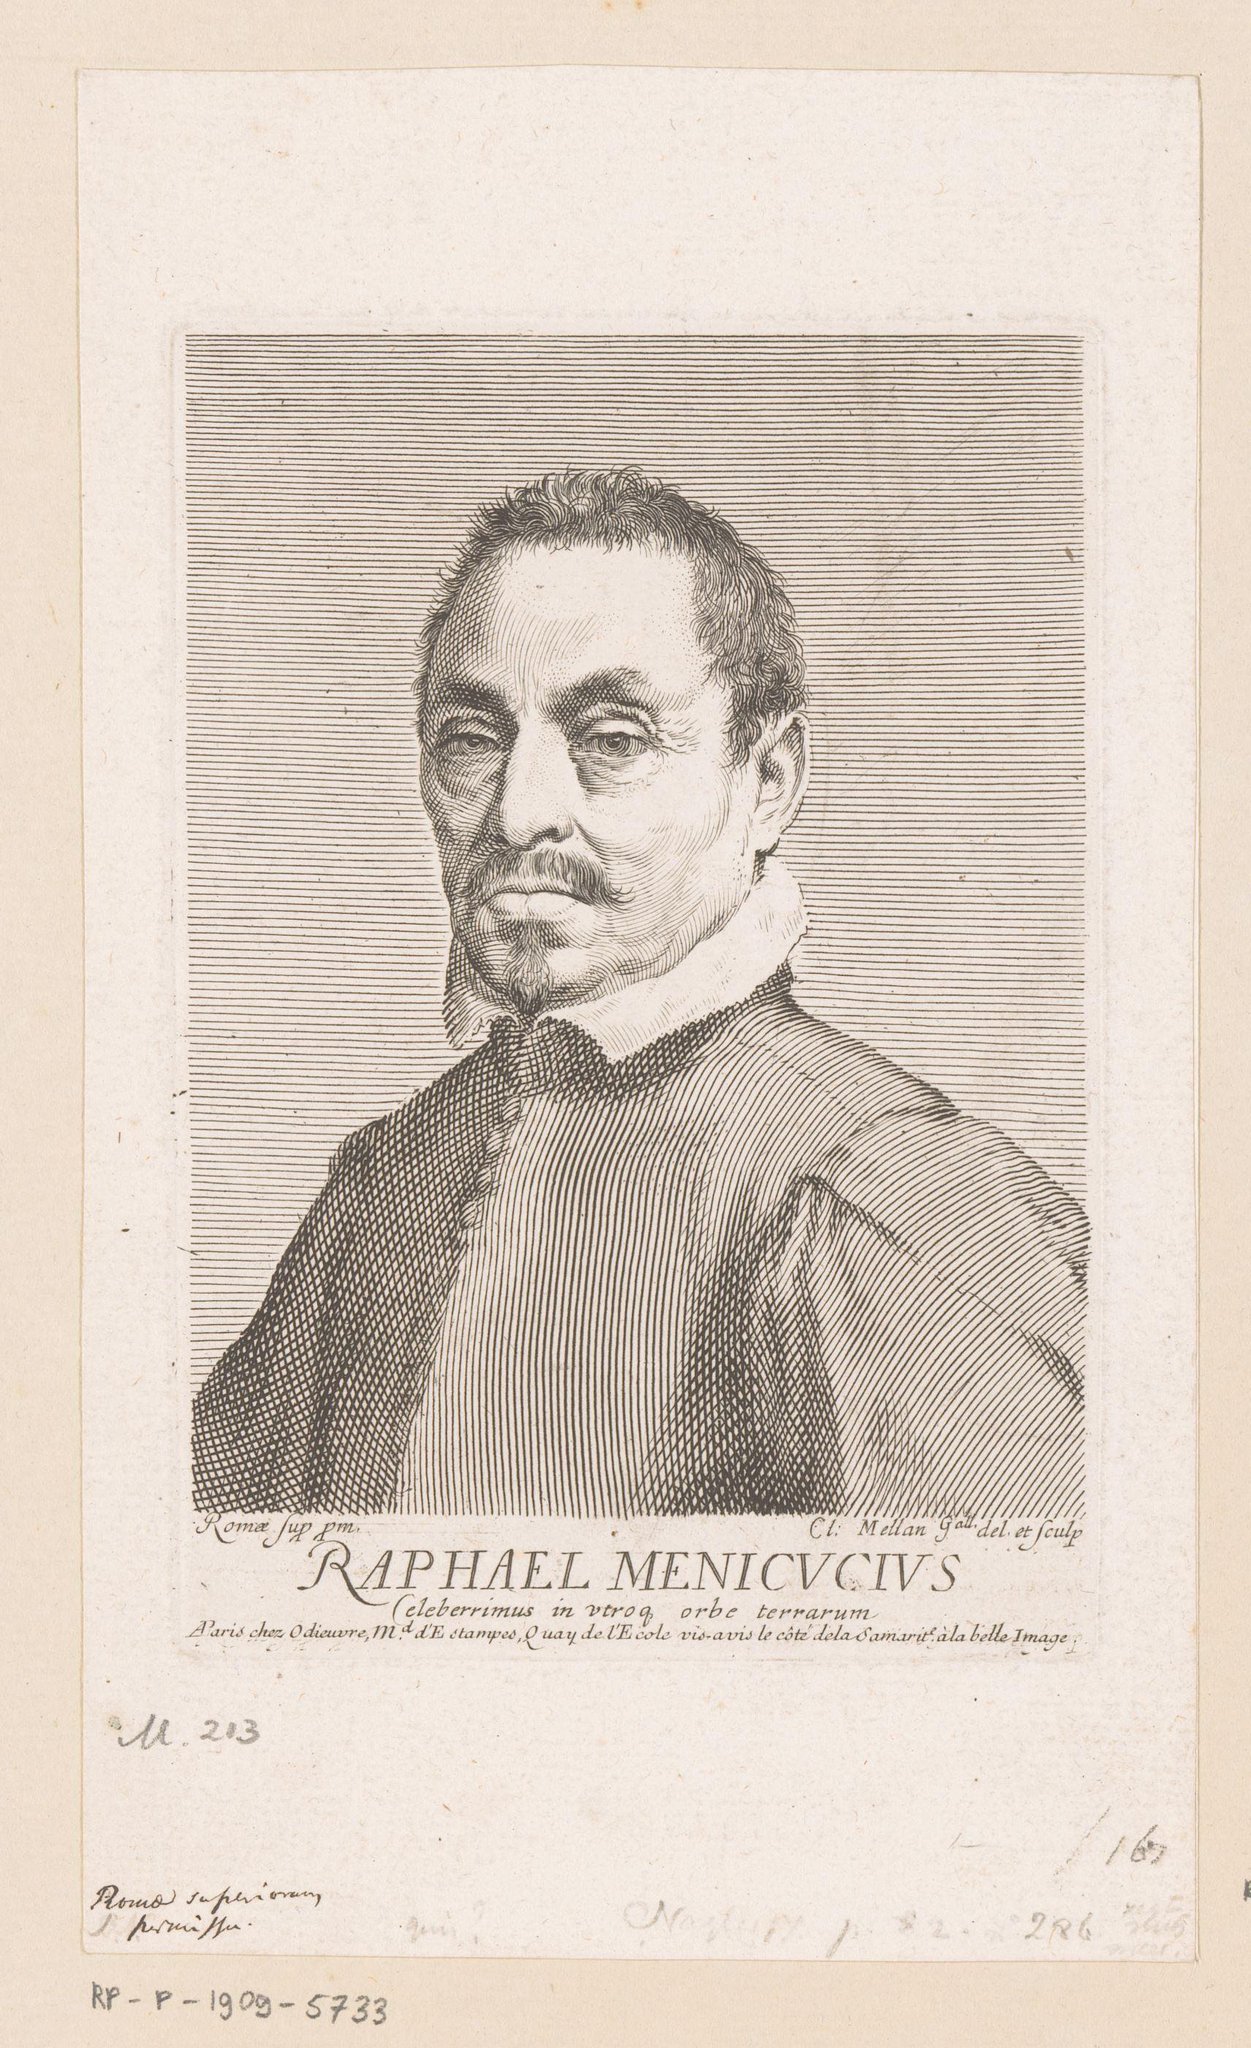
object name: print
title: Raphael Menicucius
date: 1624-1636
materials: paper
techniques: engraving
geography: rome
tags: historical persons, portrait of a musician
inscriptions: collector's mark: Lugt 2228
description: Prent uit: Dreux du Radier, Jean-François. L'Europe illustré, contenant l'histoire abregée des souverains, des princes, des prélats, des ministres, (...) en Europe: dans le XVe. siècle compris, jusqu'à présent. Parijs: Michel Odieuvre en Jean-Luc Nyon, 1755-1765. De plaat bevindt zich in het Musée du Département des Estampes.